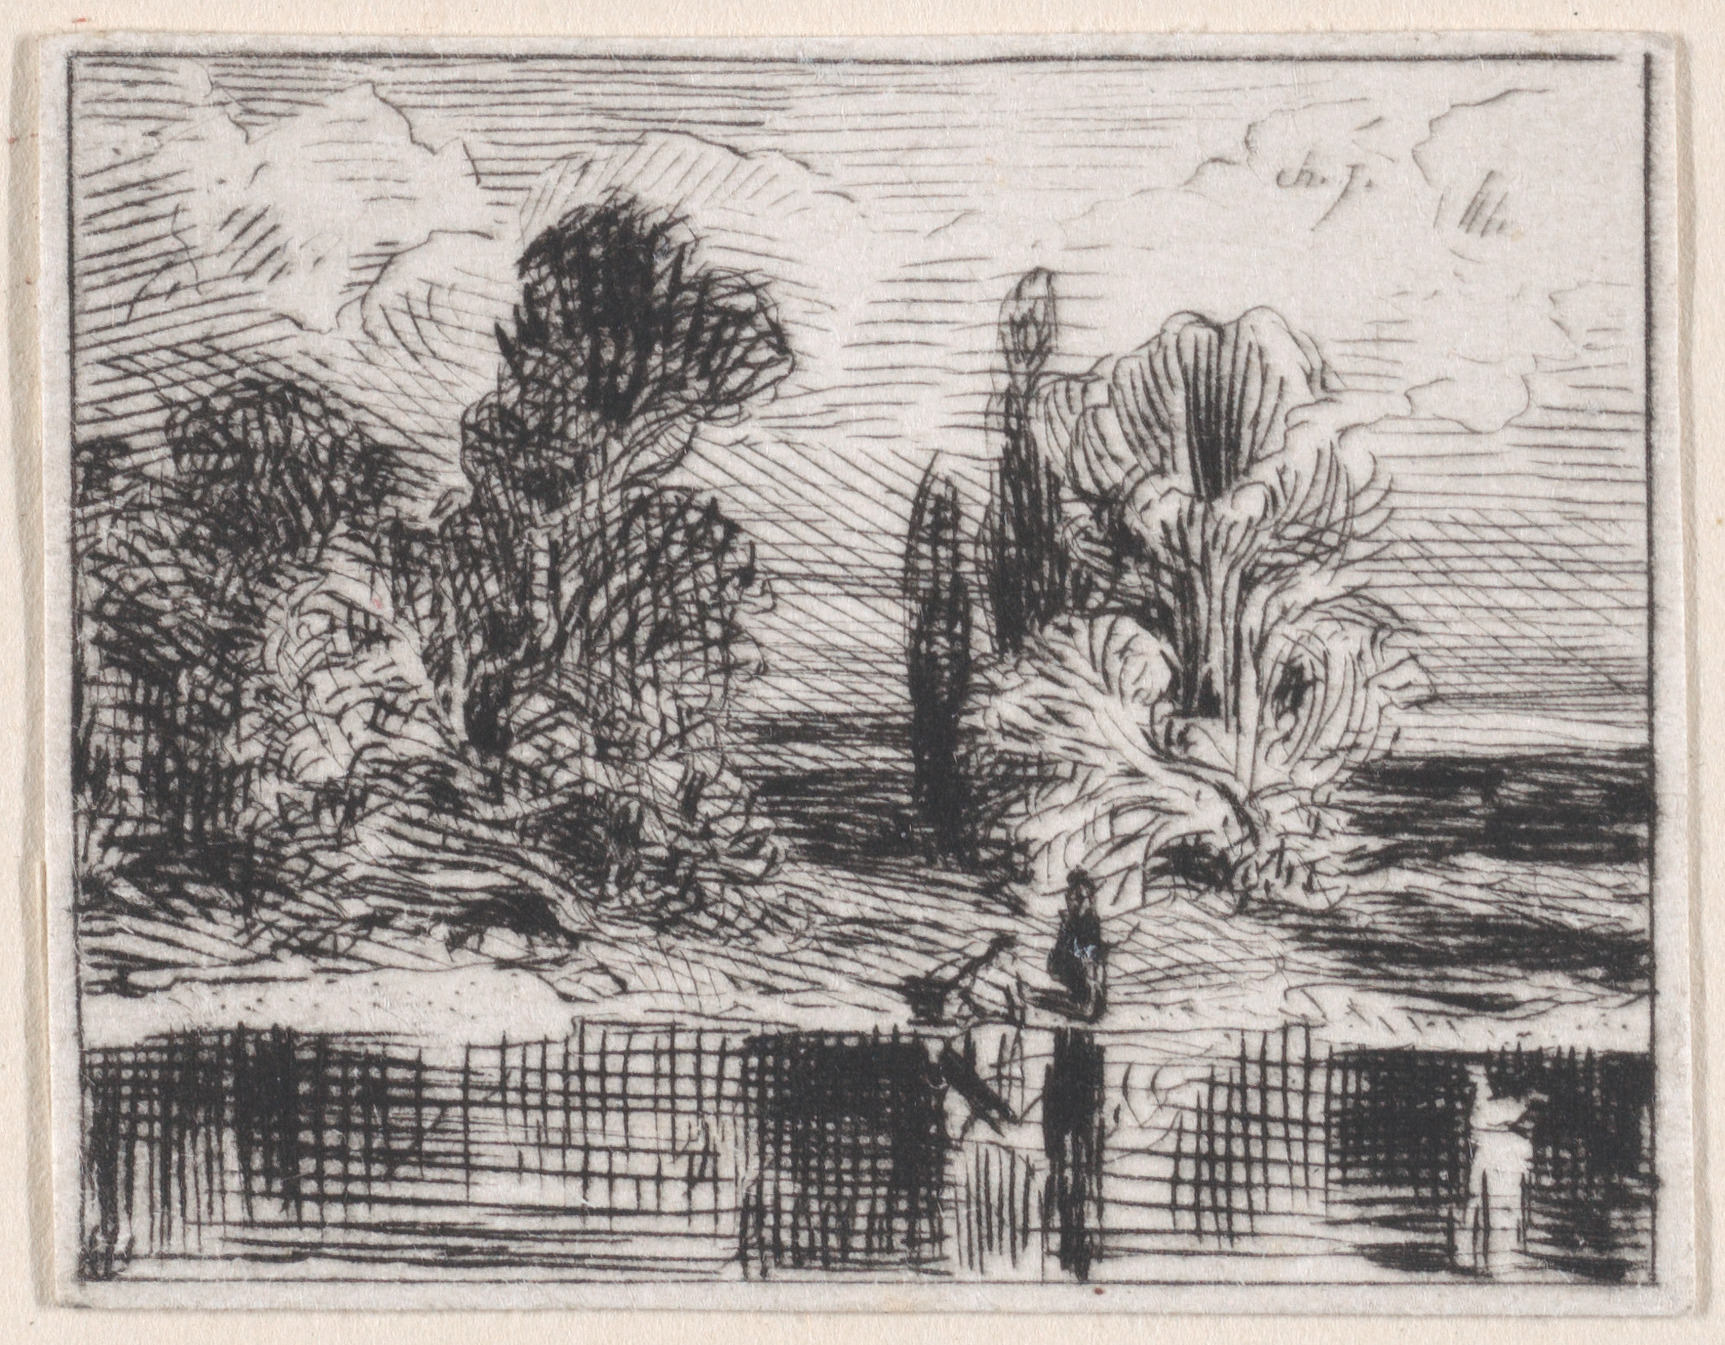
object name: print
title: Landscape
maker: charles émile jacque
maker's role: artist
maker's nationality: french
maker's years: 1813-1894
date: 1843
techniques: drypoint